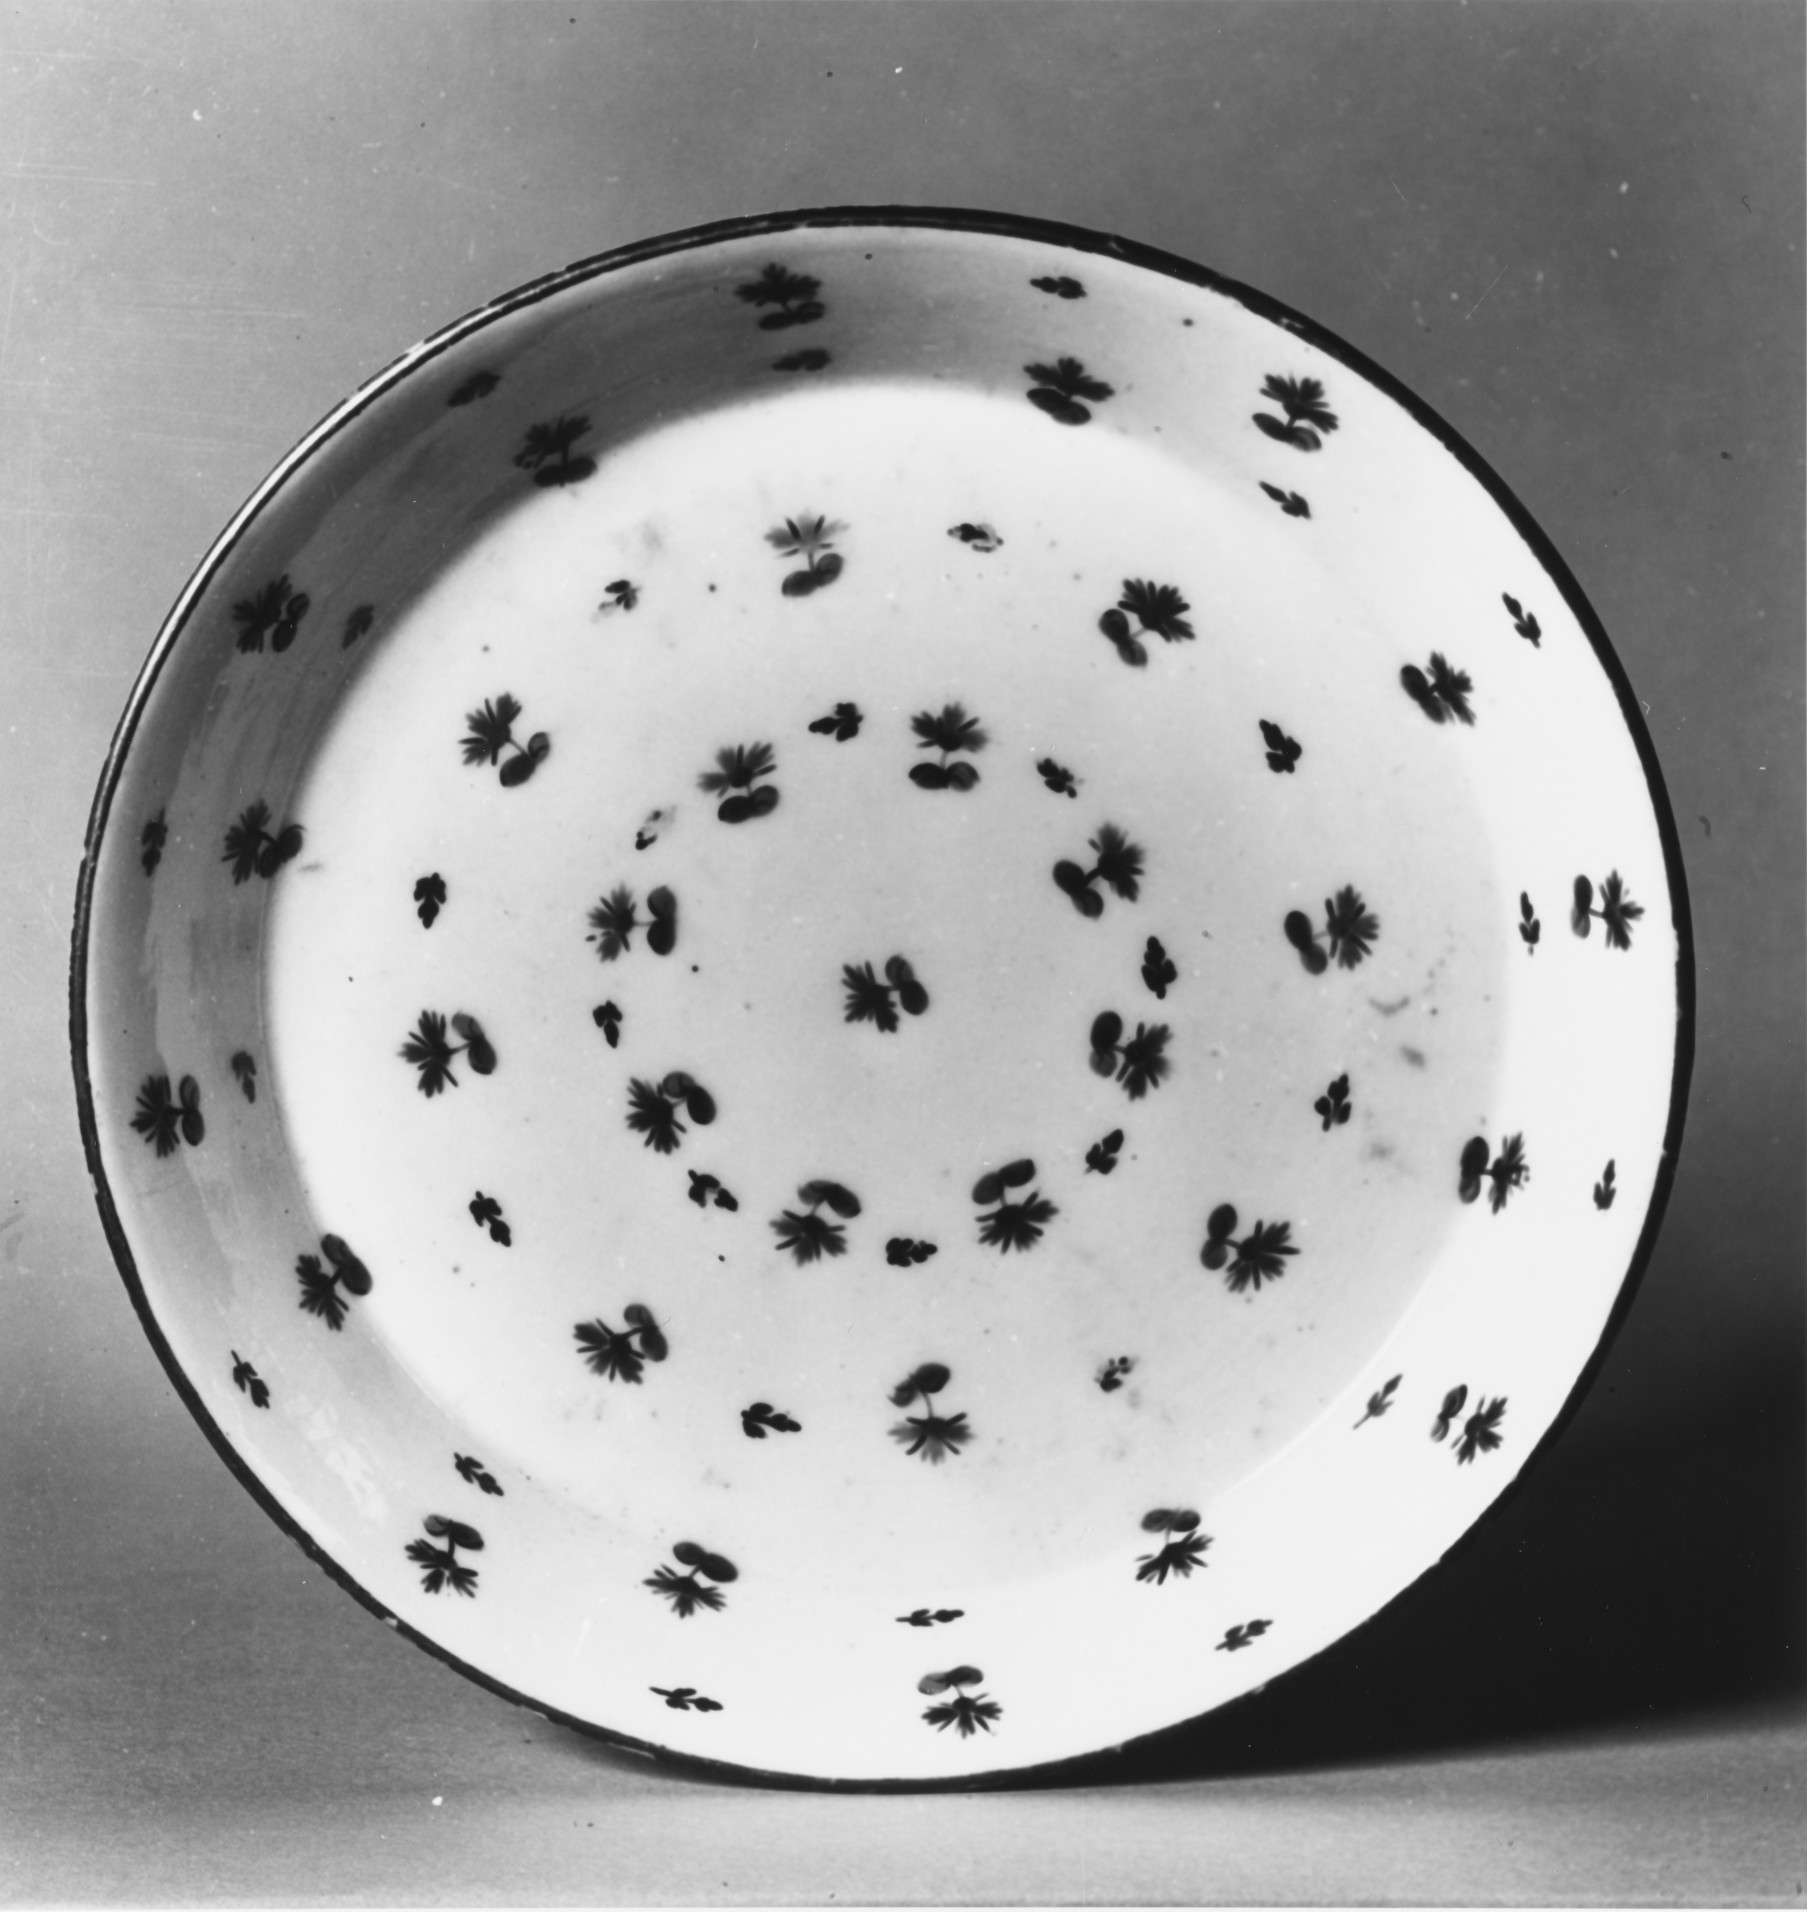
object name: dish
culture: french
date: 1780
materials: porcelain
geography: france